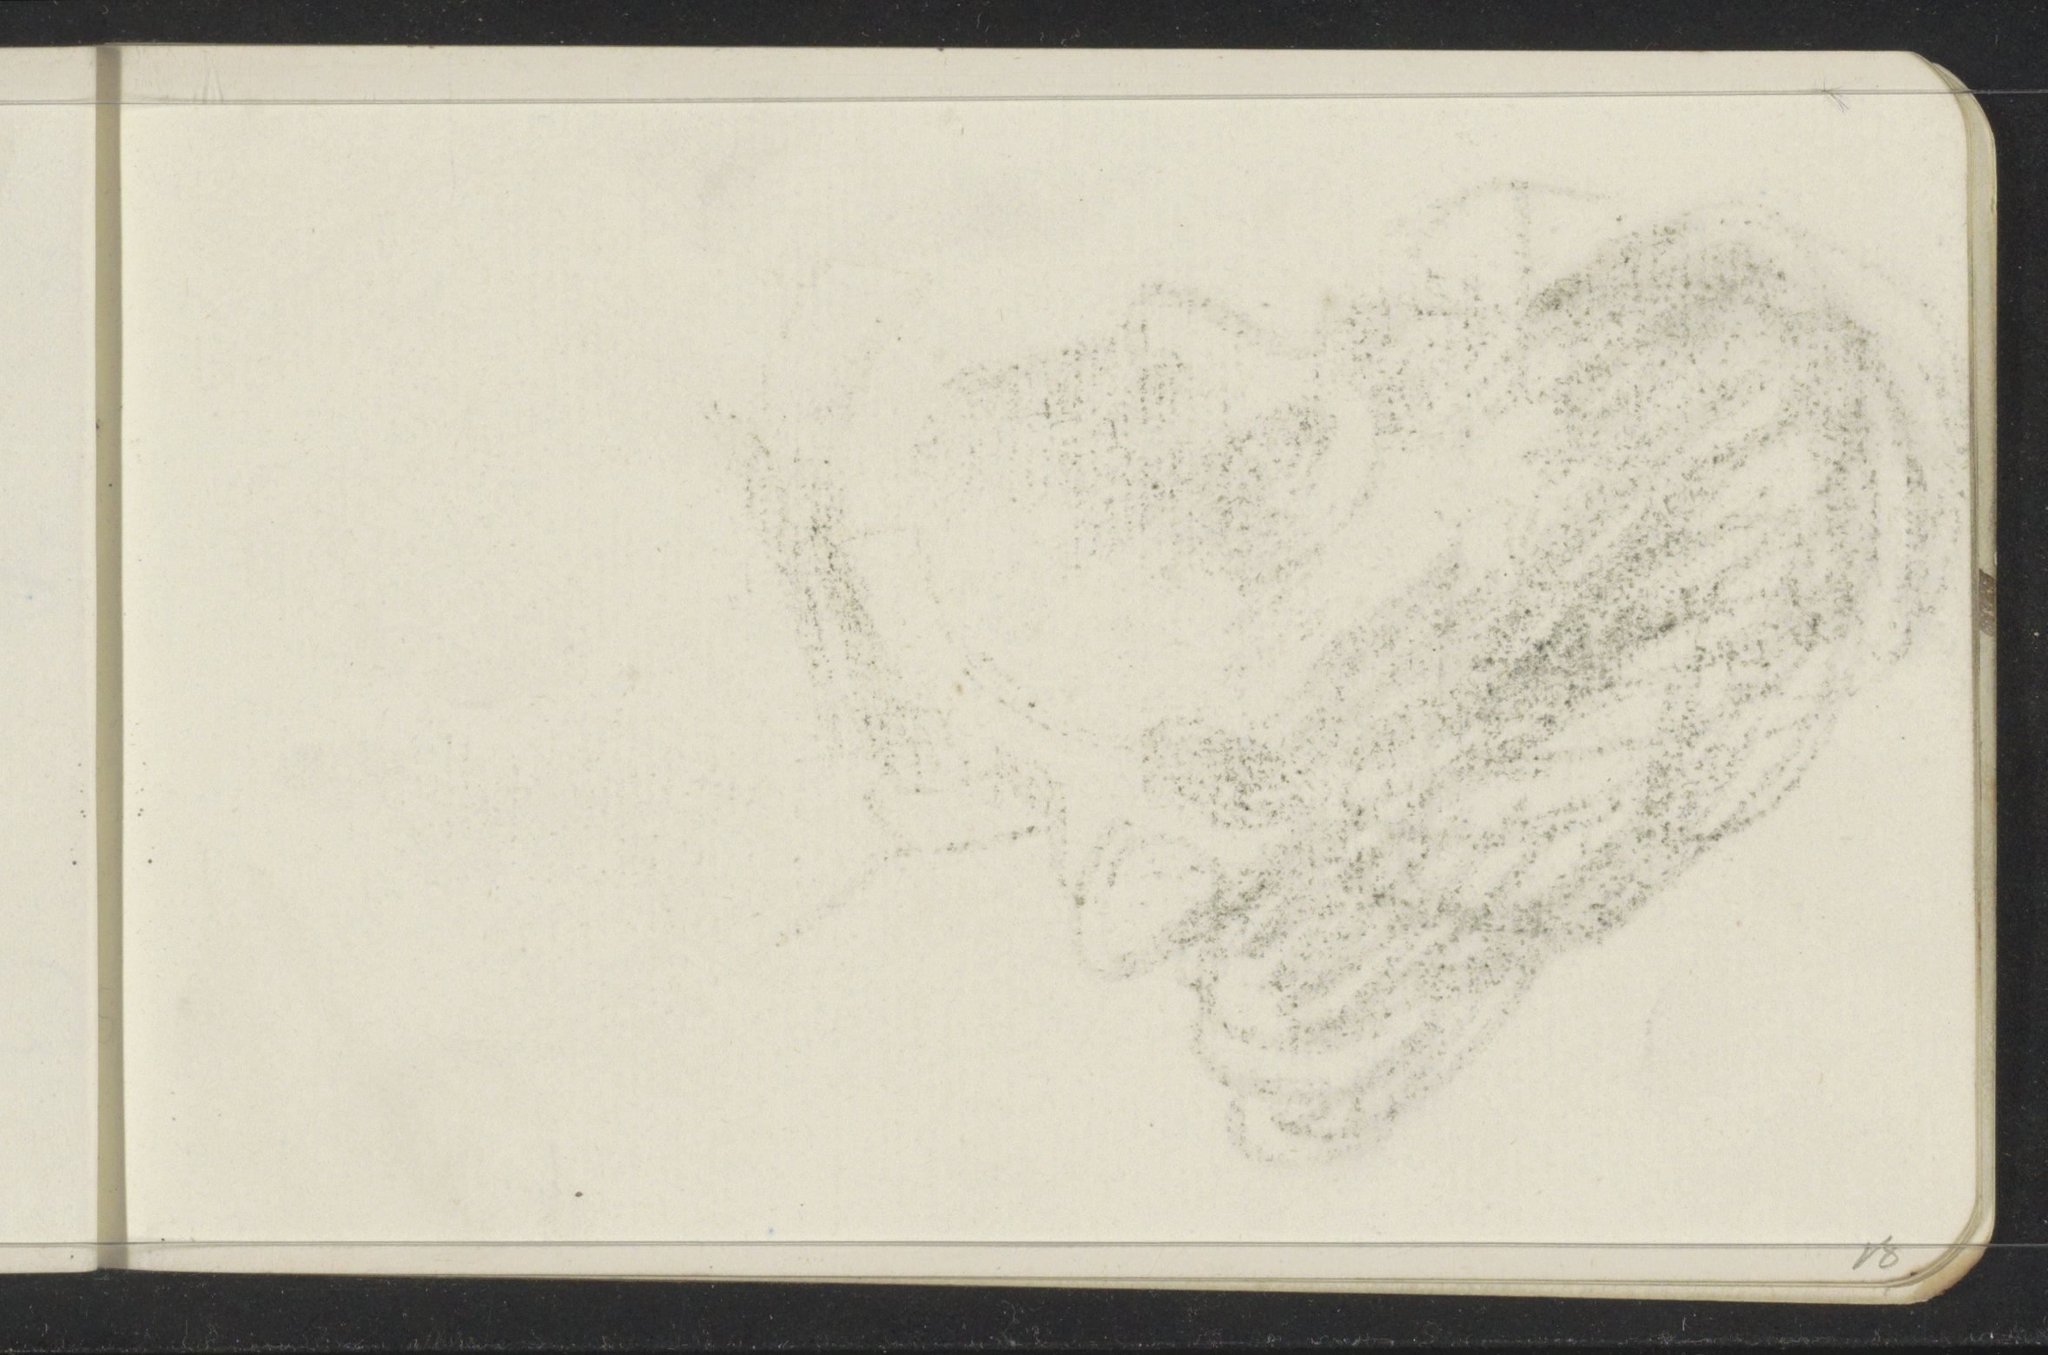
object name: sketchbook leaf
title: Abklatsch van de krijttekening op blad 17 verso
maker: isaac israels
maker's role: draughtsman, painter, print maker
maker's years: 1865-1934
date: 1875-1934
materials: paper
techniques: printmaking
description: Blad 18 recto uit schetsboek LXII met 28 bladen.